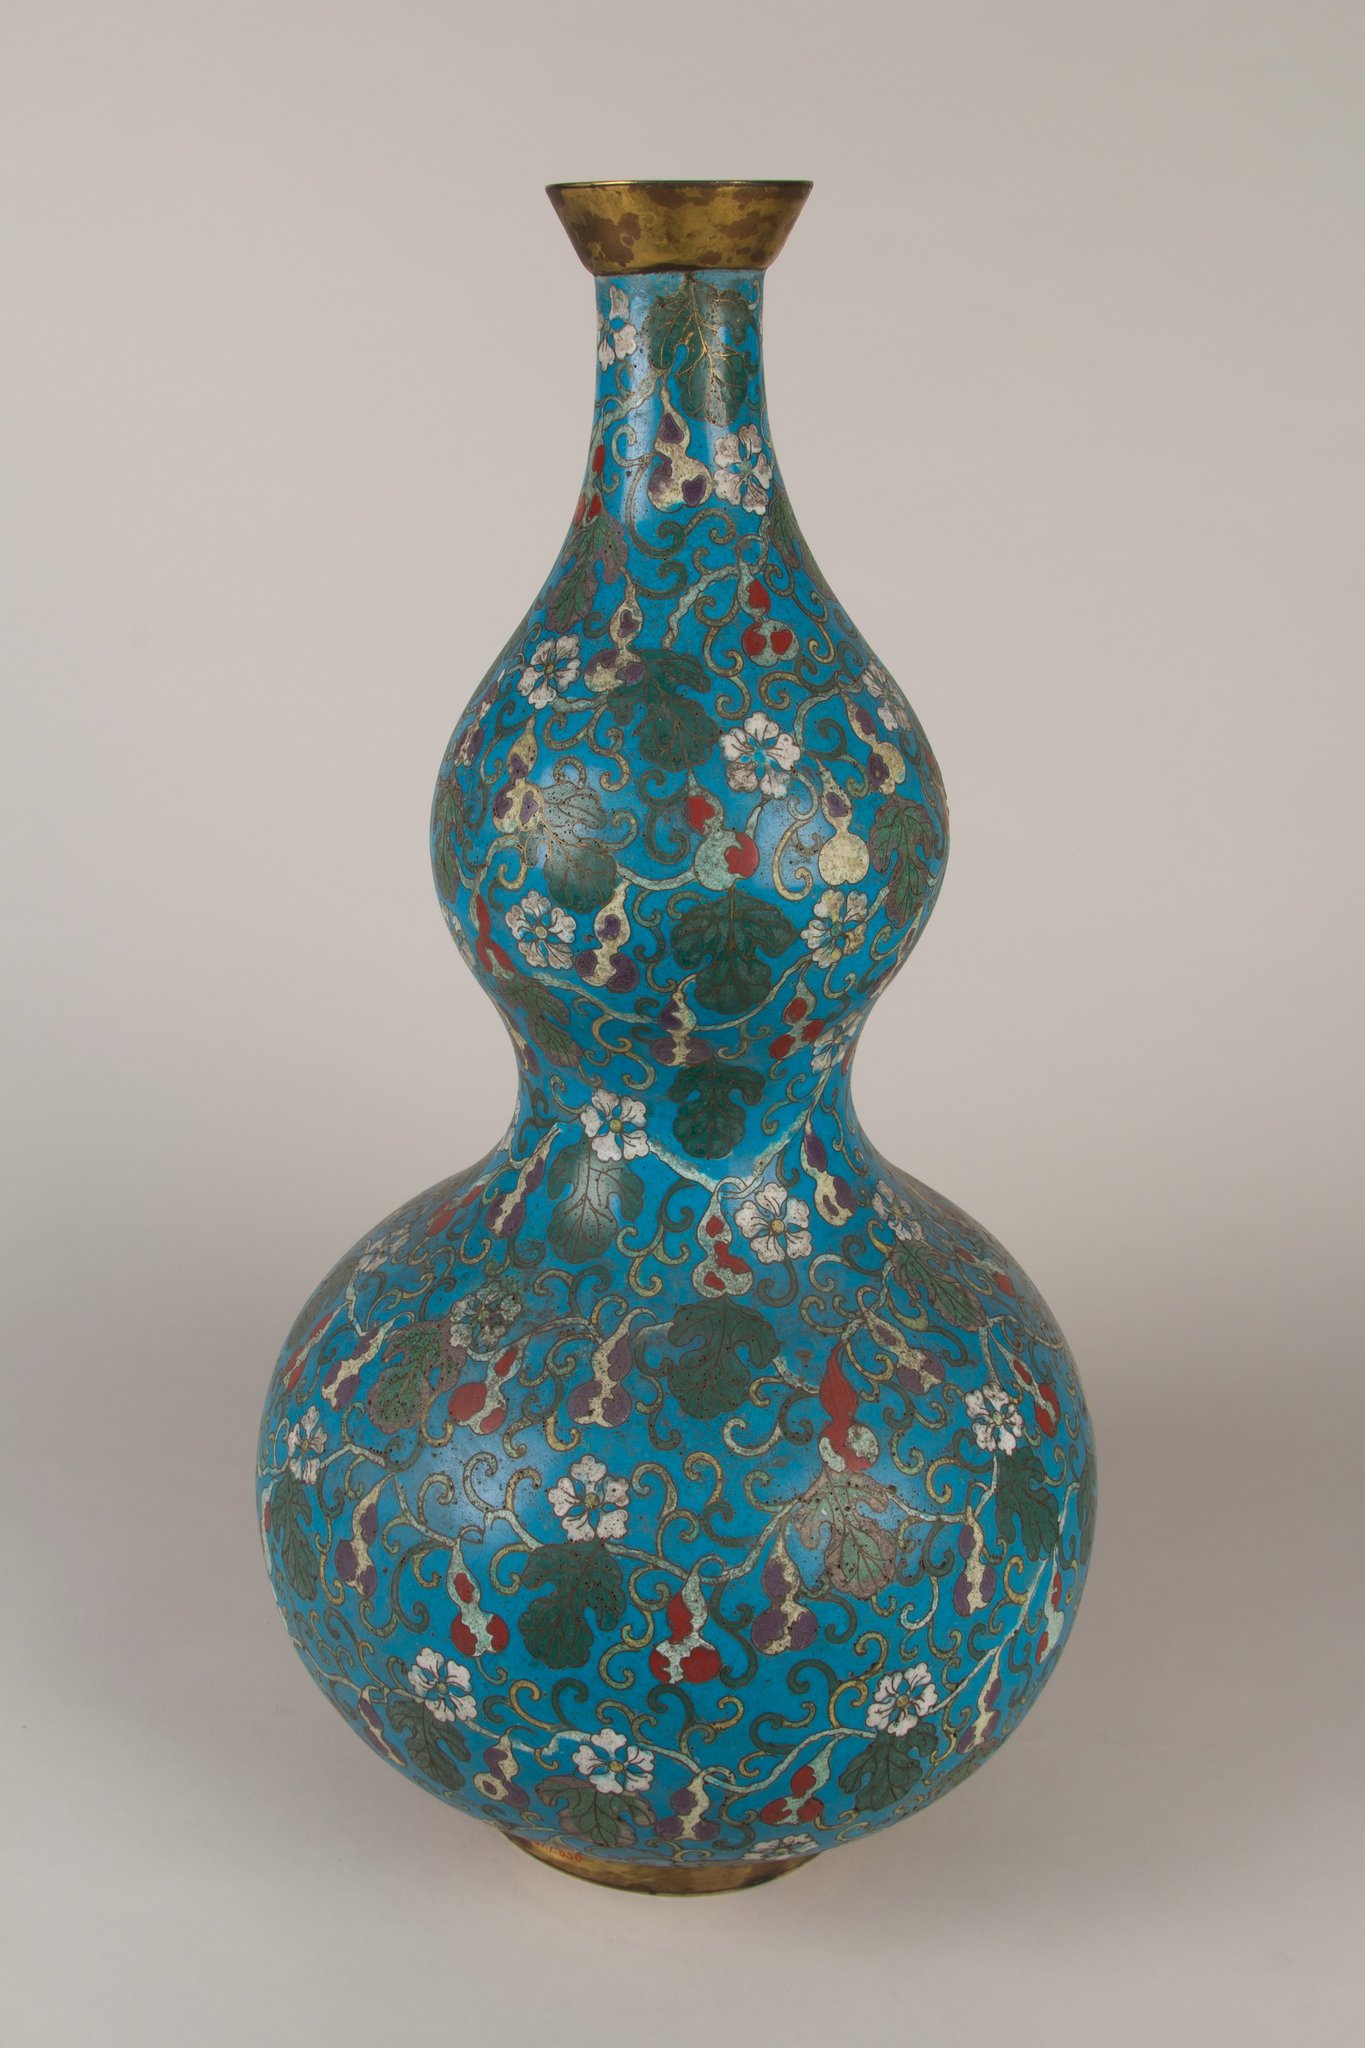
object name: vase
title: Vase (one of a pair)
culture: chinese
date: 1368-1644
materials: enamel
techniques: enamel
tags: flowers